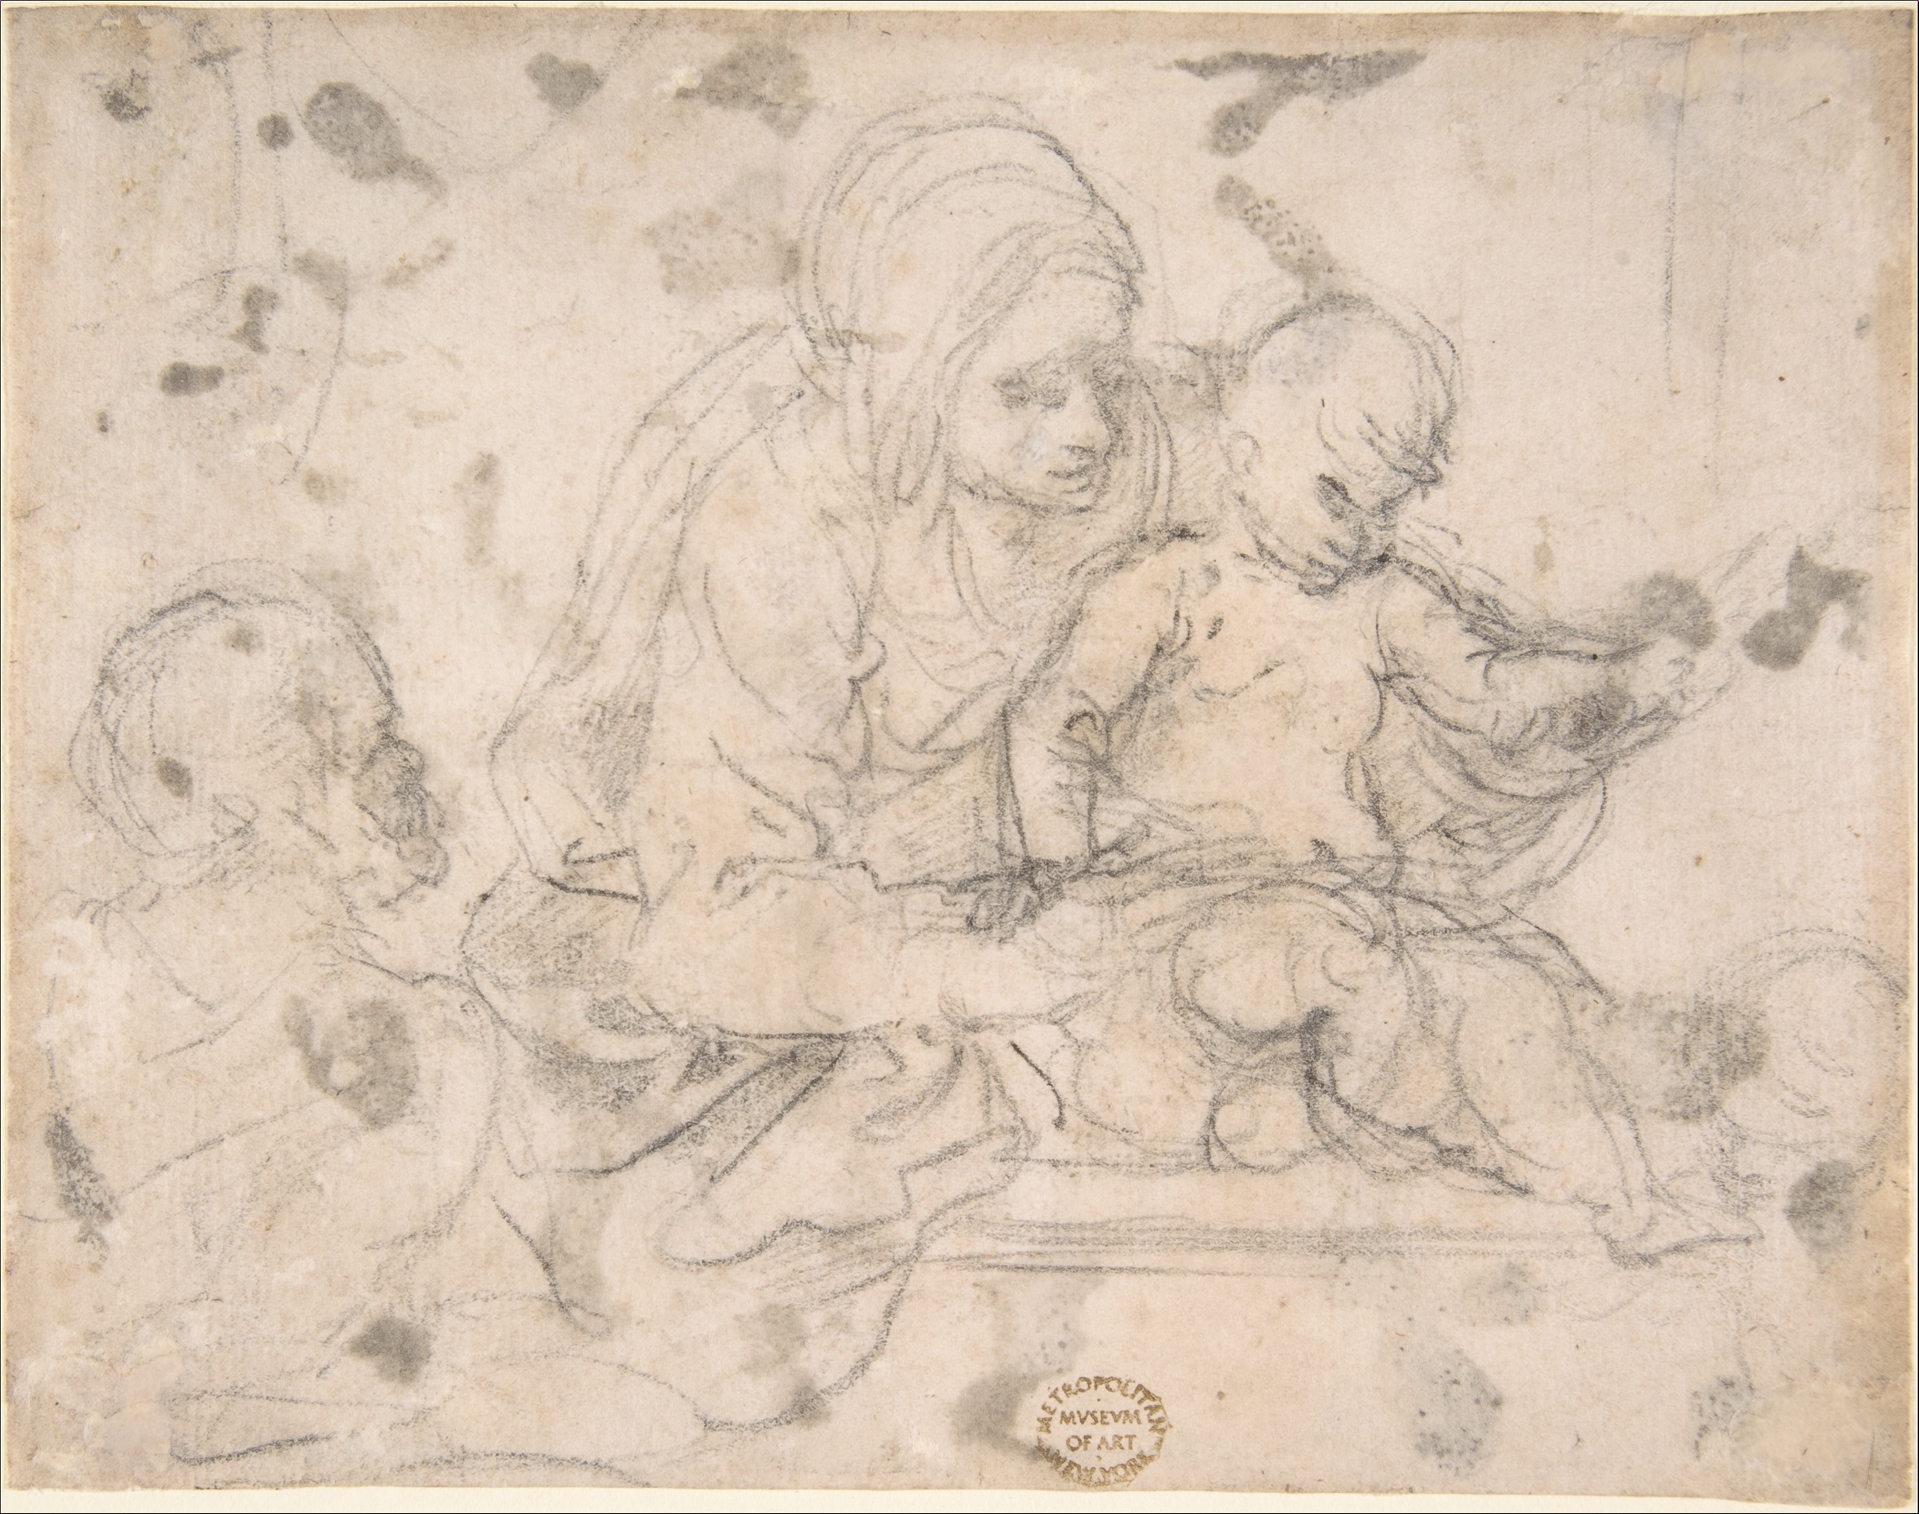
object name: drawing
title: Virgin and Child with Infant St. John the Baptist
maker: anonymous, italian, 17th century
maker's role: artist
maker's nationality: italian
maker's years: 1600-1700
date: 1601-1700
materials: chalk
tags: madonna and child,saint john the baptist